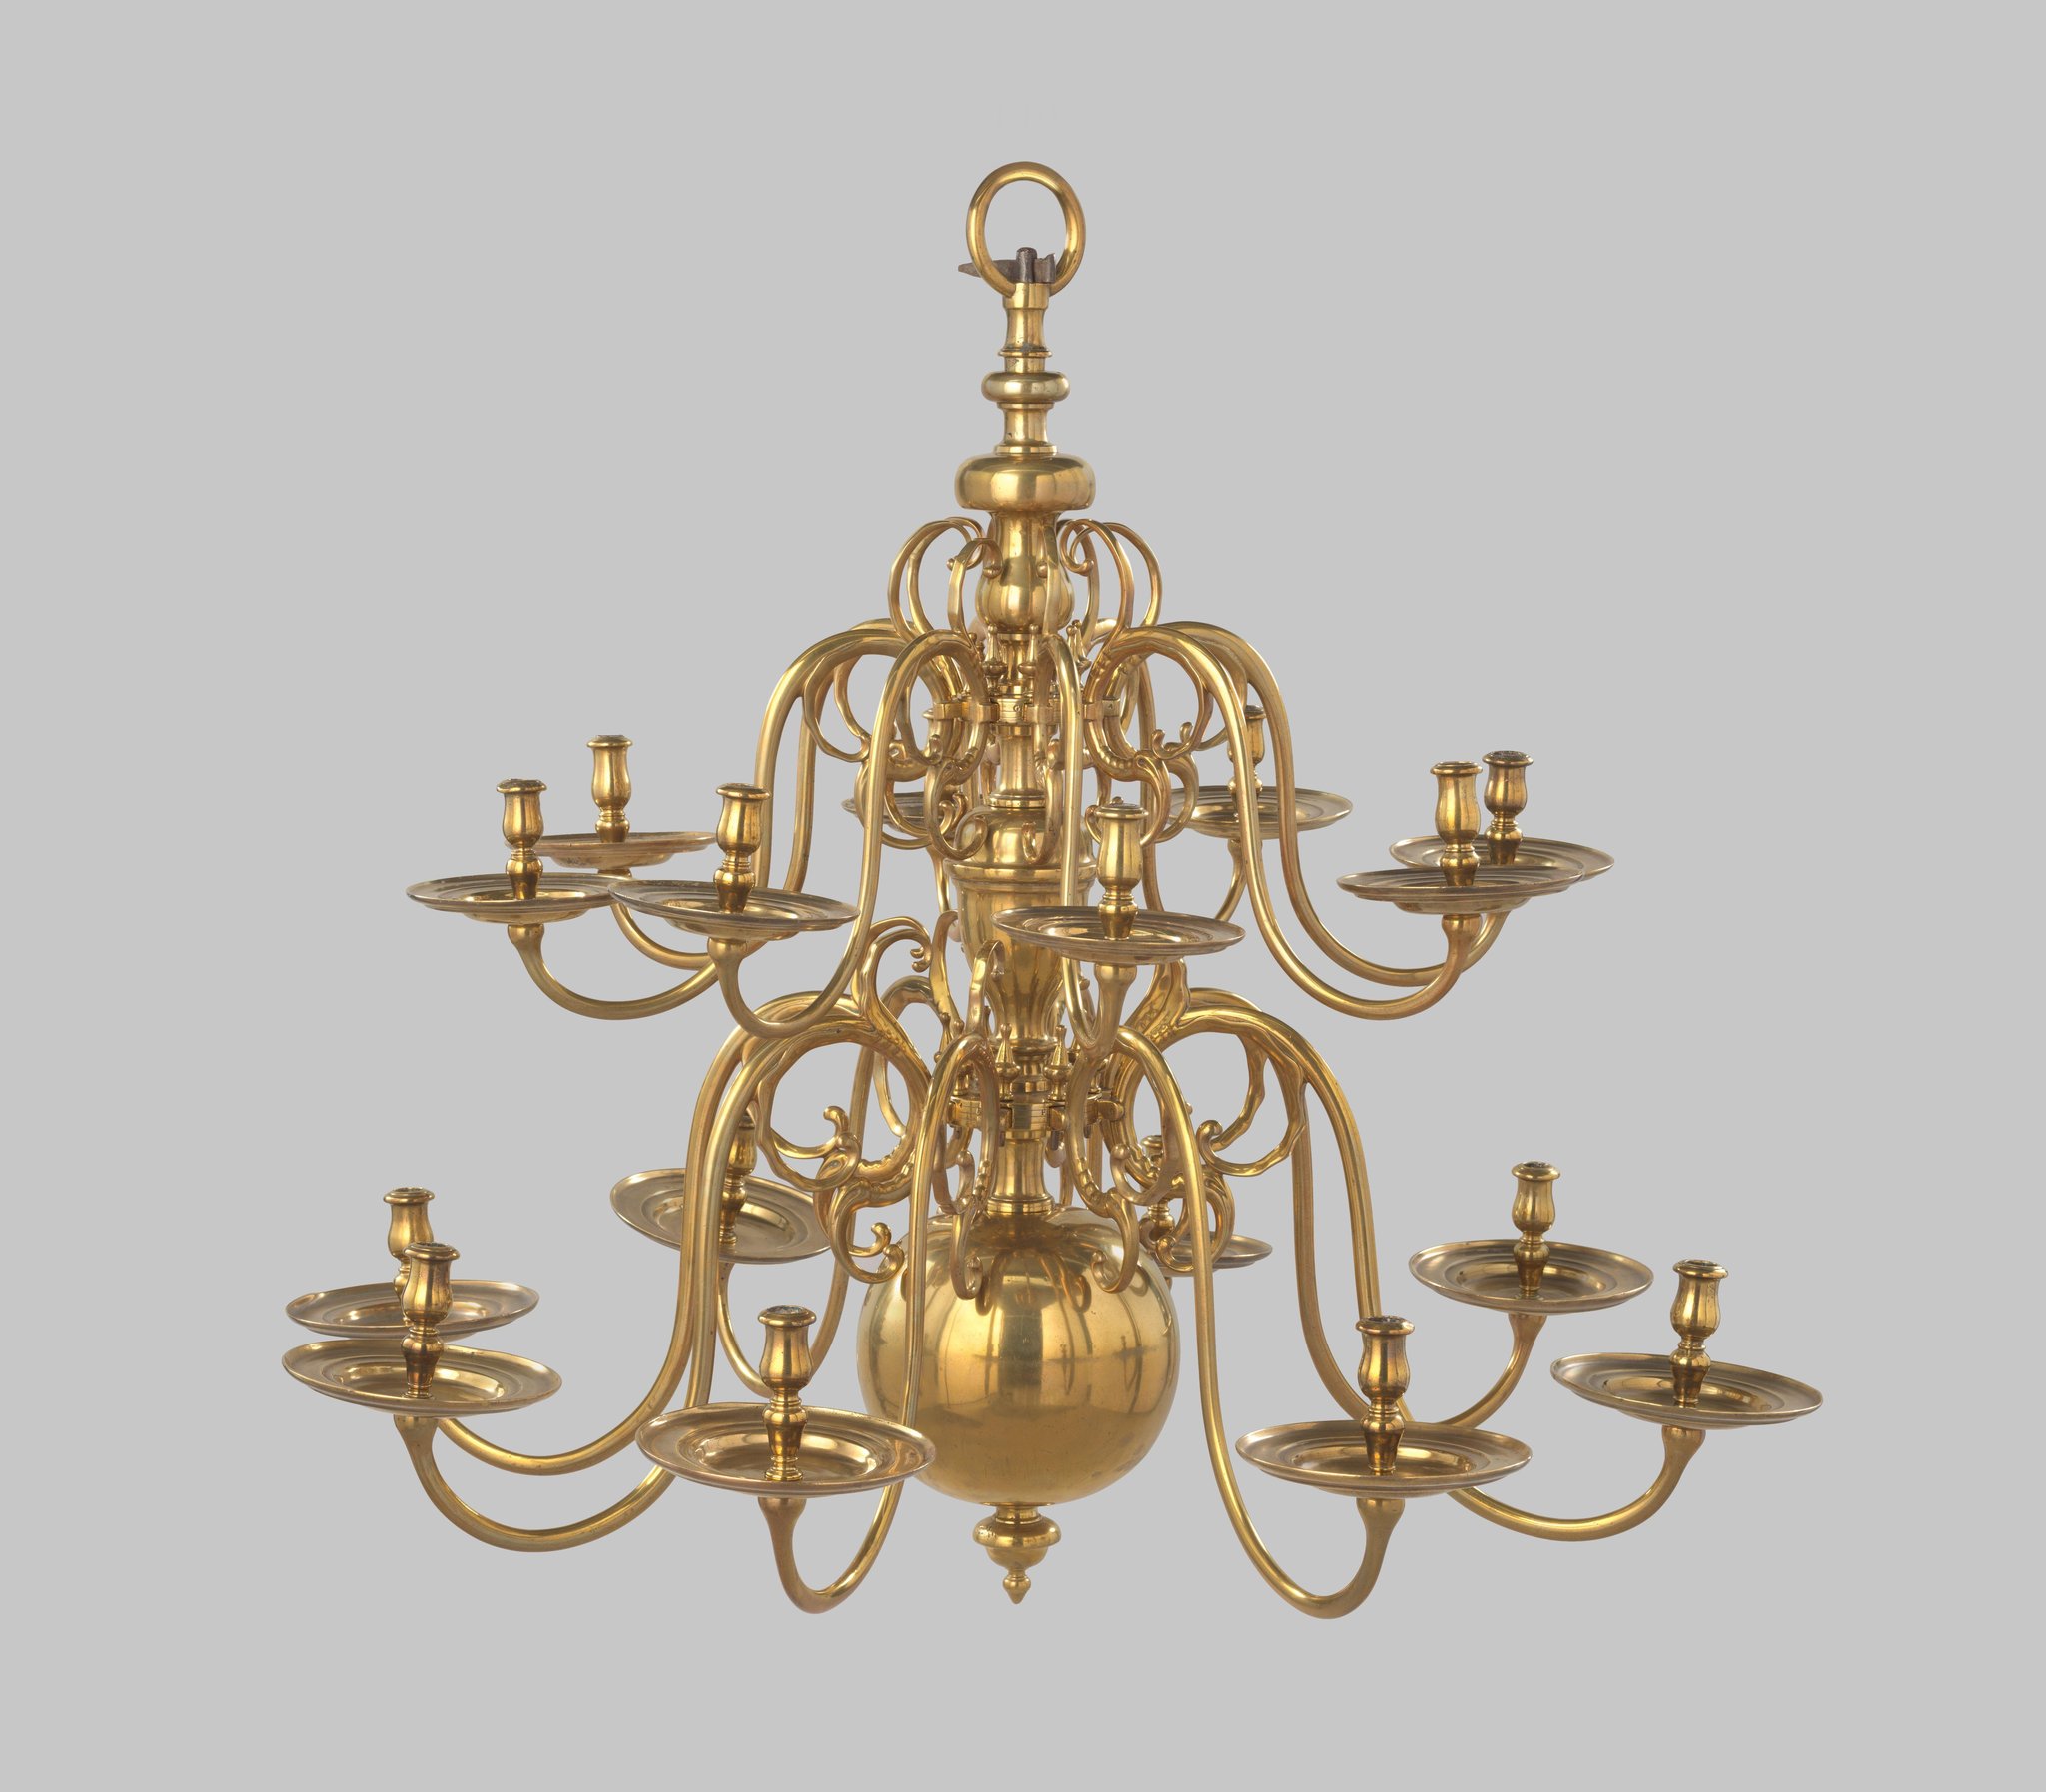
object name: chandelier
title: Arm van een kaarsenkroon in twee hoogten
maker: Anonymous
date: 1650-1675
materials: brass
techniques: screwed, turning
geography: amsterdam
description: De S-vormige arm is aan de stamzijde voorzien van een nok met een opening om deze met een pin in de standring te kunnen vastzetten. Bij de stam is de arm op het eind versierd met een gestileerde dolfijnenkop en met twee krullen, waarvan de vormgeving aan het kwabornament is ontleend. Naar buiten toe eindigt de arm in een verdikking, waarin een van een schroefdraad voorzien gat is aangebracht ter bevestiging van de kaarsenhouder met de vetvanger. De arm is met behulp van hetzelfde model gegoten als de overige armen van de krans en heeft dezelfe grootte. De kaarsenhouder heeft een ronde zich naar boven toe versmallende en in een uitstekende rand overgaande vaasvorm op balustervoet met een van een schroefdraad voorzien eind, waarin onderaan het centergat. De vetvanger is aan de bovenkant naar het midden toe één keer verdiept. Aan de onderkant is zij geprofileerd op de rand en rond het gat op het enigszins bolvormige midden. De vetvanger heeft telkens zijn eigen grootte en is met behulp van hetzelfde model gegoten als de overige vetvangers van deze krans. De pin is voorzien van een knop in vaasvorm. Dit is de zesde arm van de bovenste standring, genummerd op de nok met de letter F.